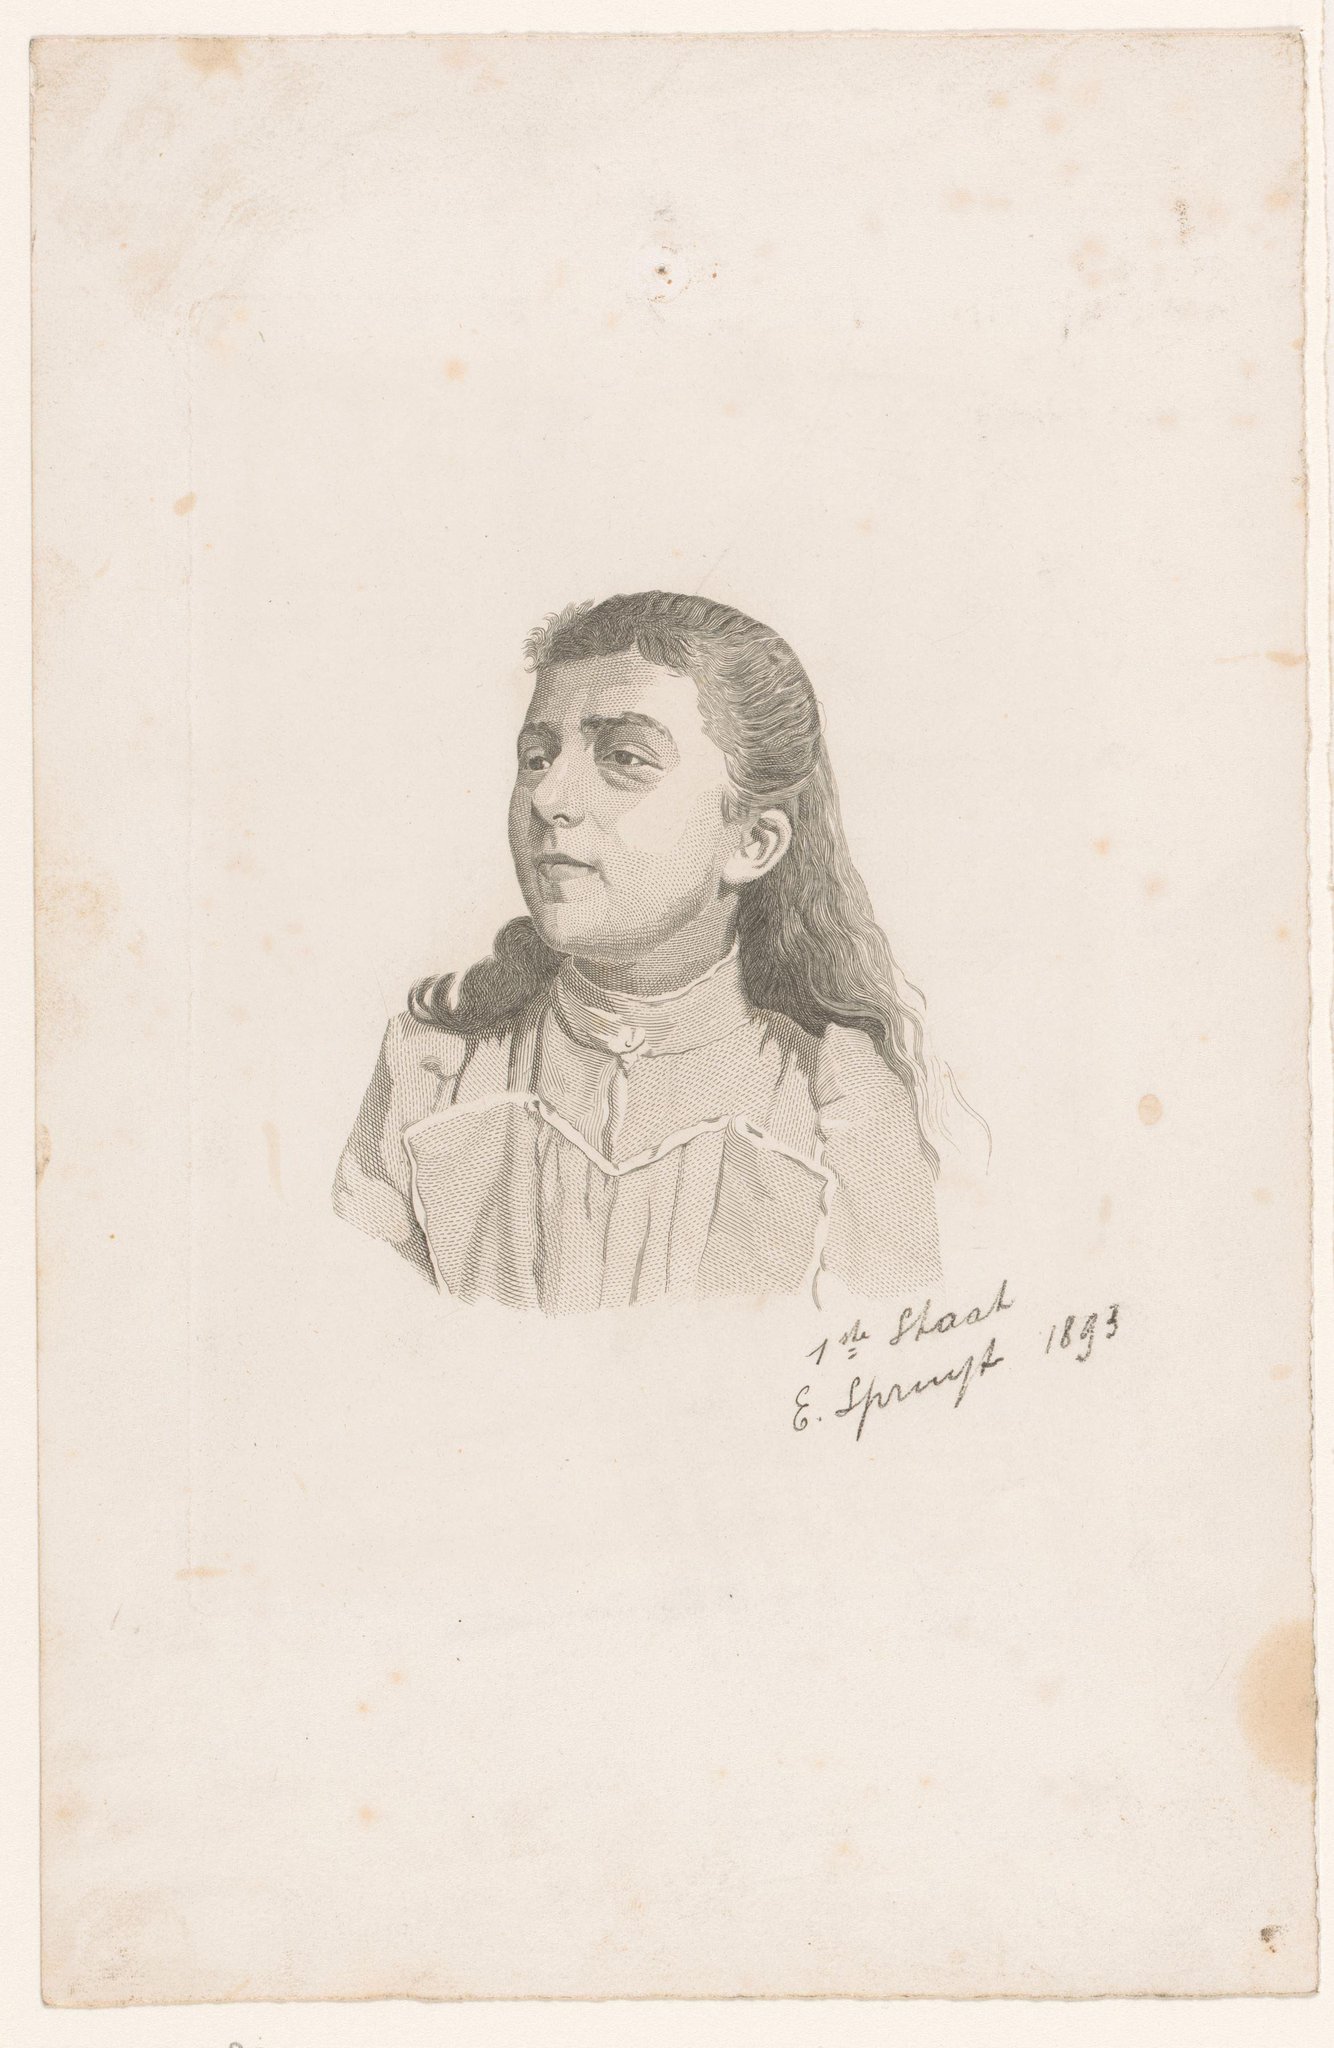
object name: print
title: Portret van een onbekende jonge vrouw, mogelijk de zus van Emile Spruyt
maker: emile pierre maria spruyt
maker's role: print maker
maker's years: 1870-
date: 1893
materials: paper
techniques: etching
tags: adolescent, young woman, maiden, historical persons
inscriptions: inscription: ‘1 ste staat’, collector's mark: Lugt 2228